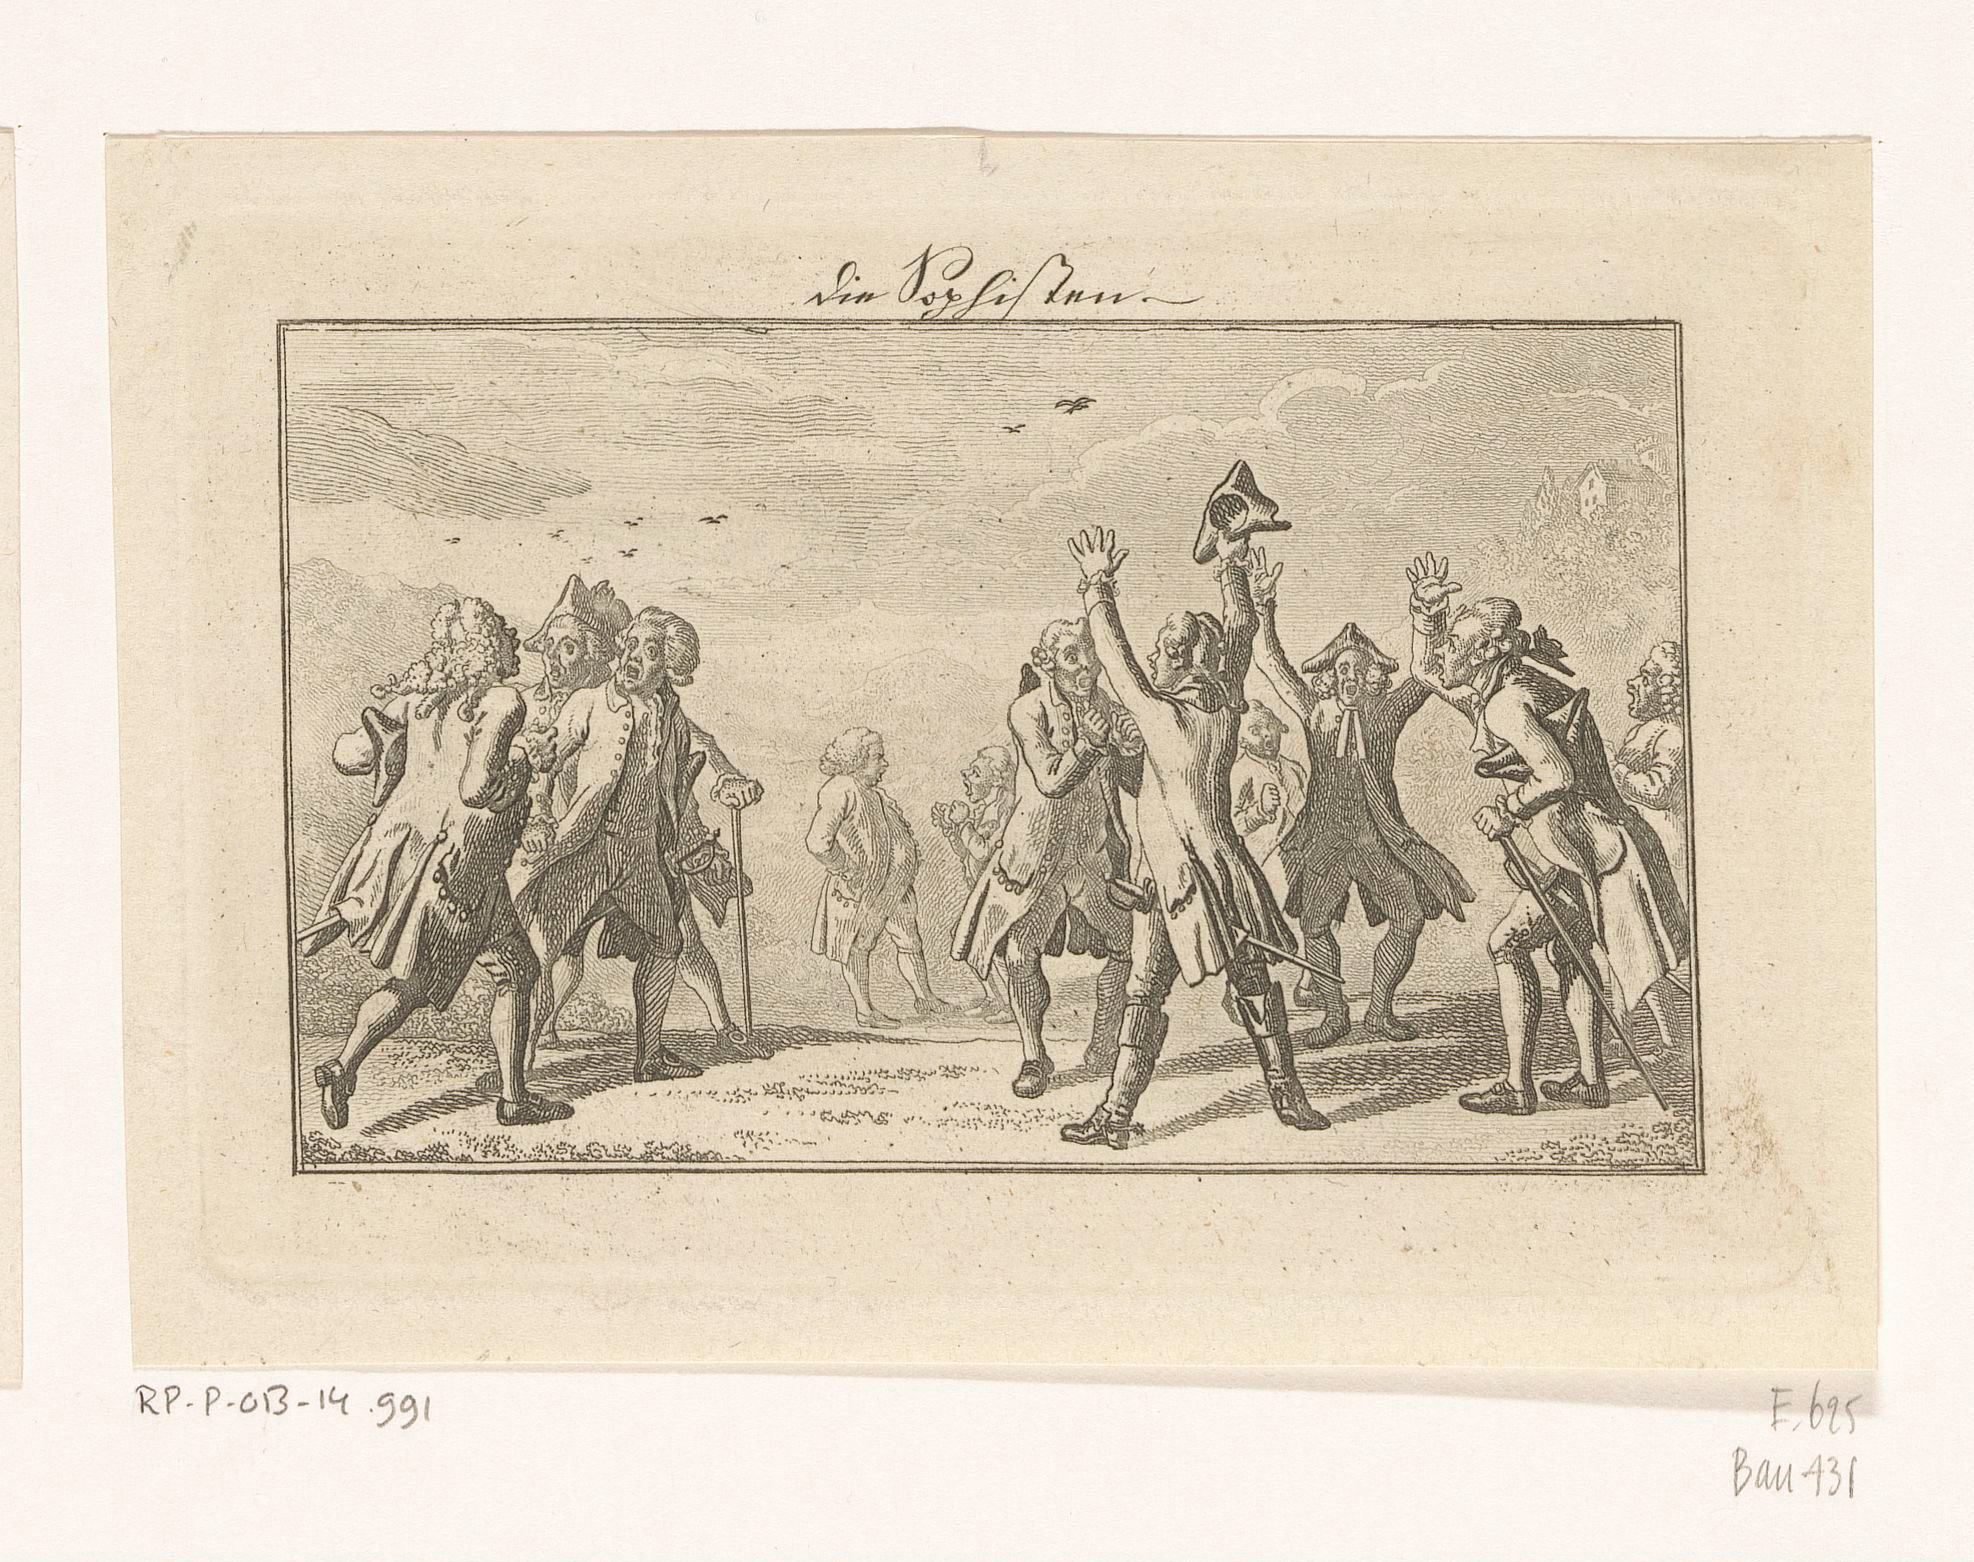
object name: print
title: Elf hevig gesticulerende mannen in een landschap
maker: daniel nikolaus chodowiecki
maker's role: draughtsman, print maker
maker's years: 1726-1801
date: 1790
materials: paper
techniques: etching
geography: berlin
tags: draughtsman, matthias claudius, gesture-language, literature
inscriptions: collector's mark: Lugt 2228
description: Prent ook gebruikt in 'Asmus omnia sua secum portans, oder Sämtliche Werke des Wandsbecker Bothen', een verzamelwerk in de vorm van een tijdschrift, uitgegeven tussen 1775-1812.